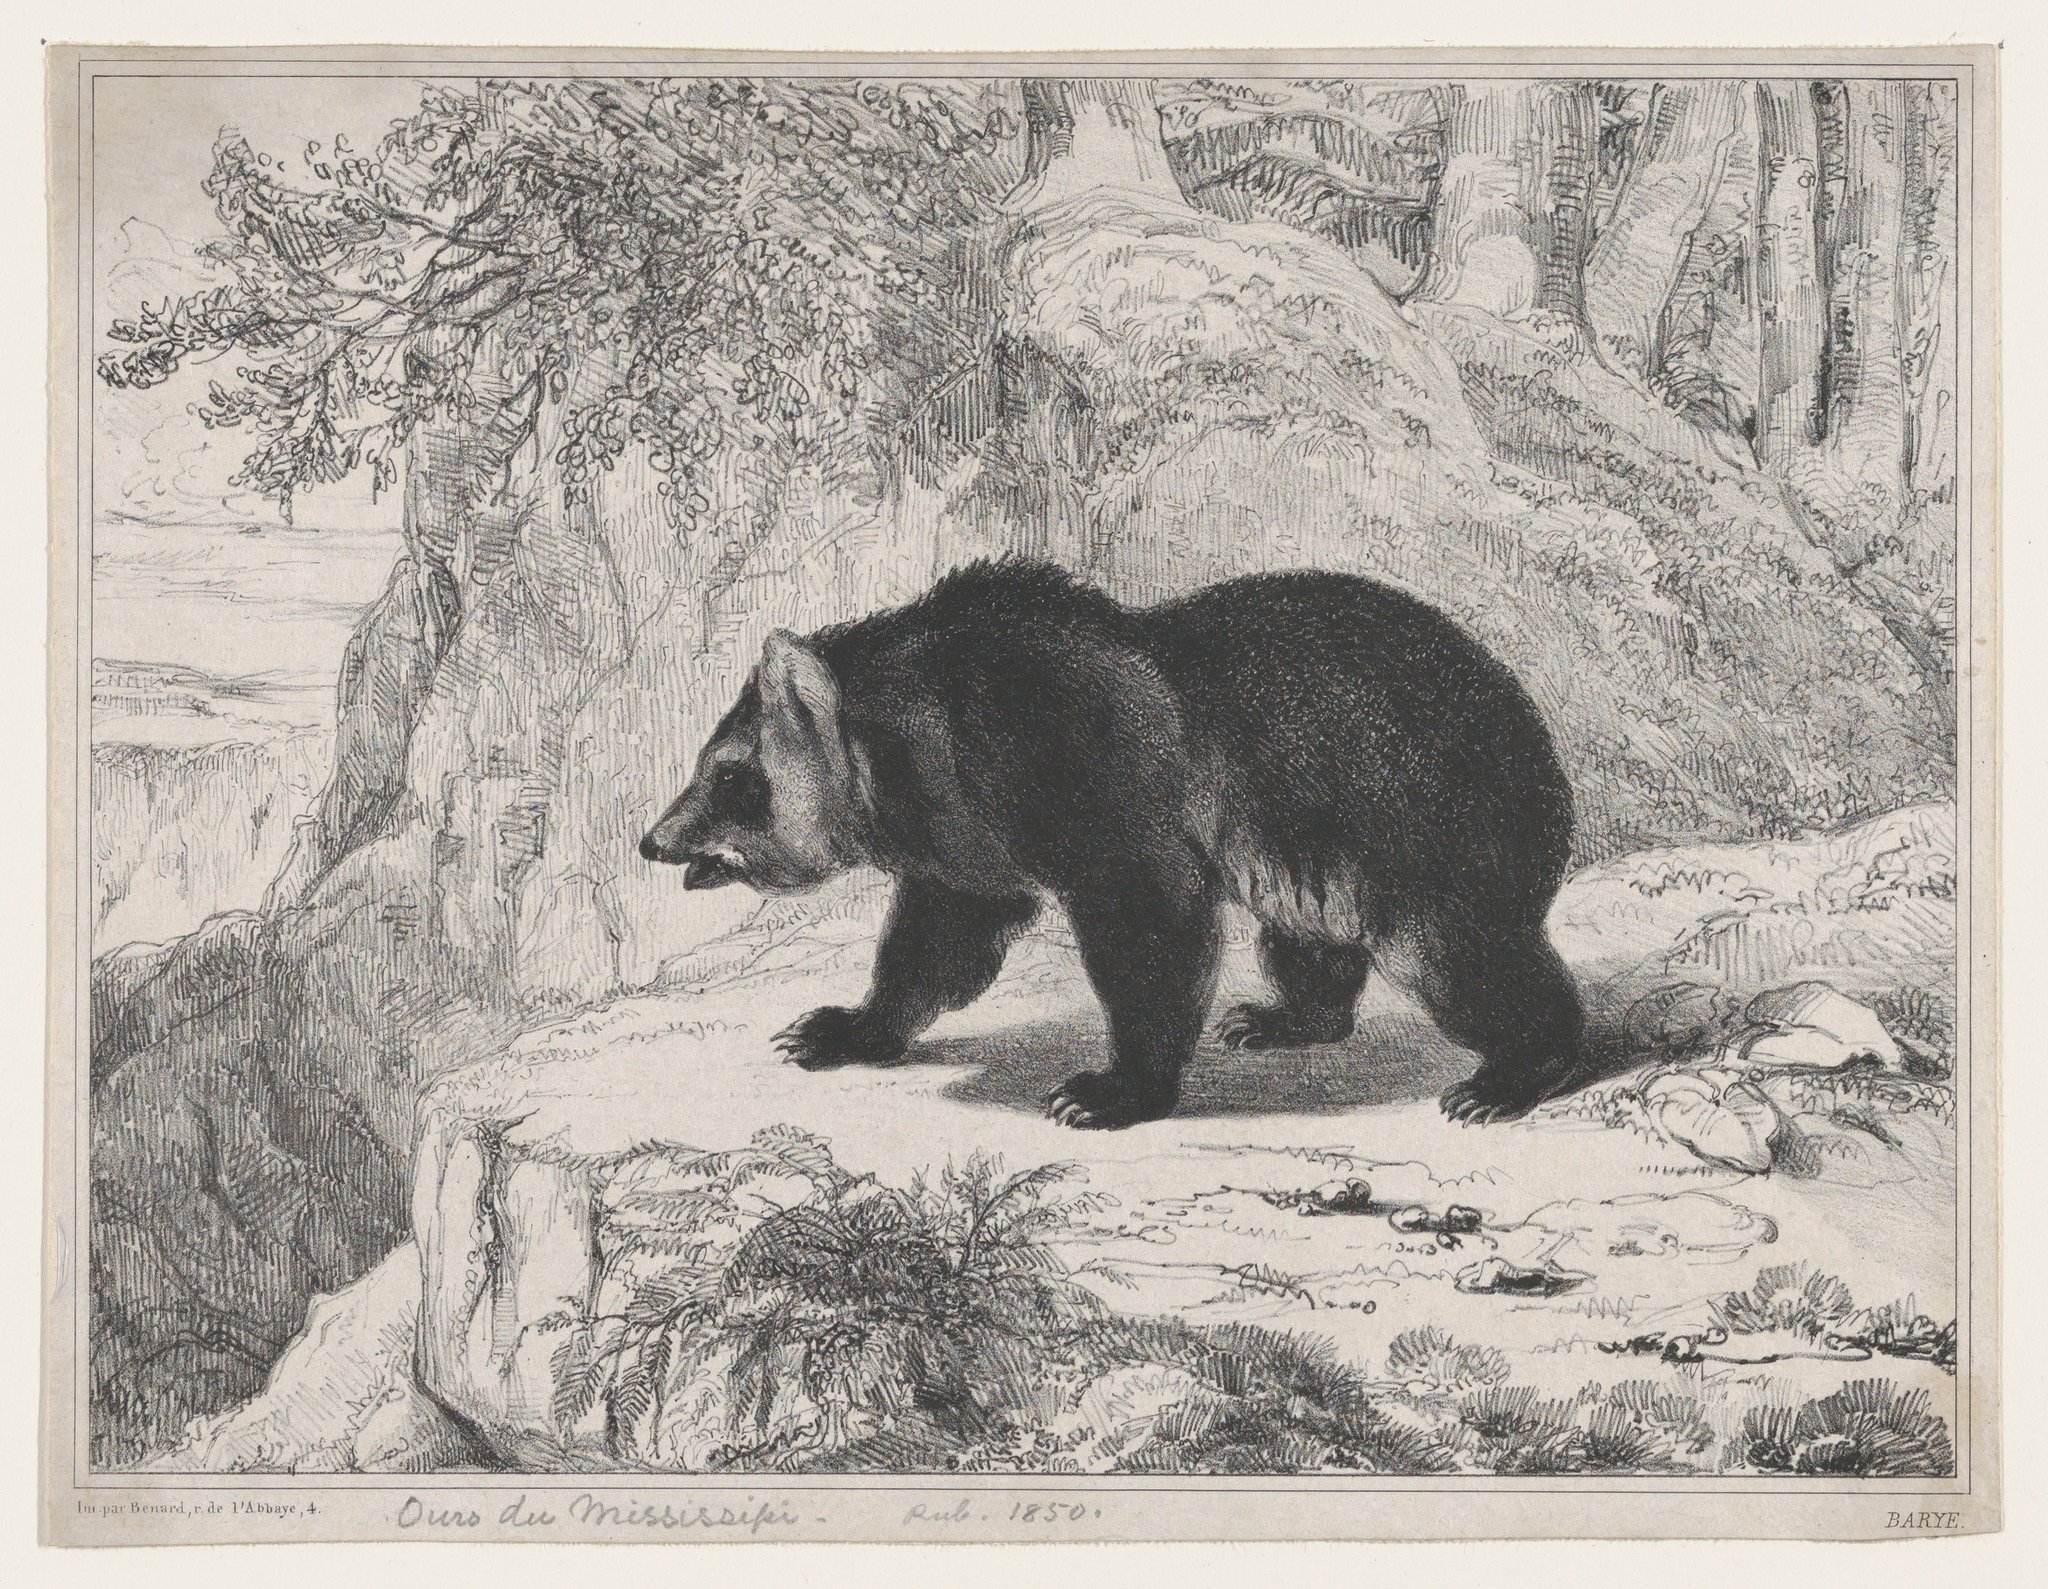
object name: print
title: Mississippi Bear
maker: antoine-louis barye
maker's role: artist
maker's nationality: french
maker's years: 1795-1875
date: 1836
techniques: lithograph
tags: bears